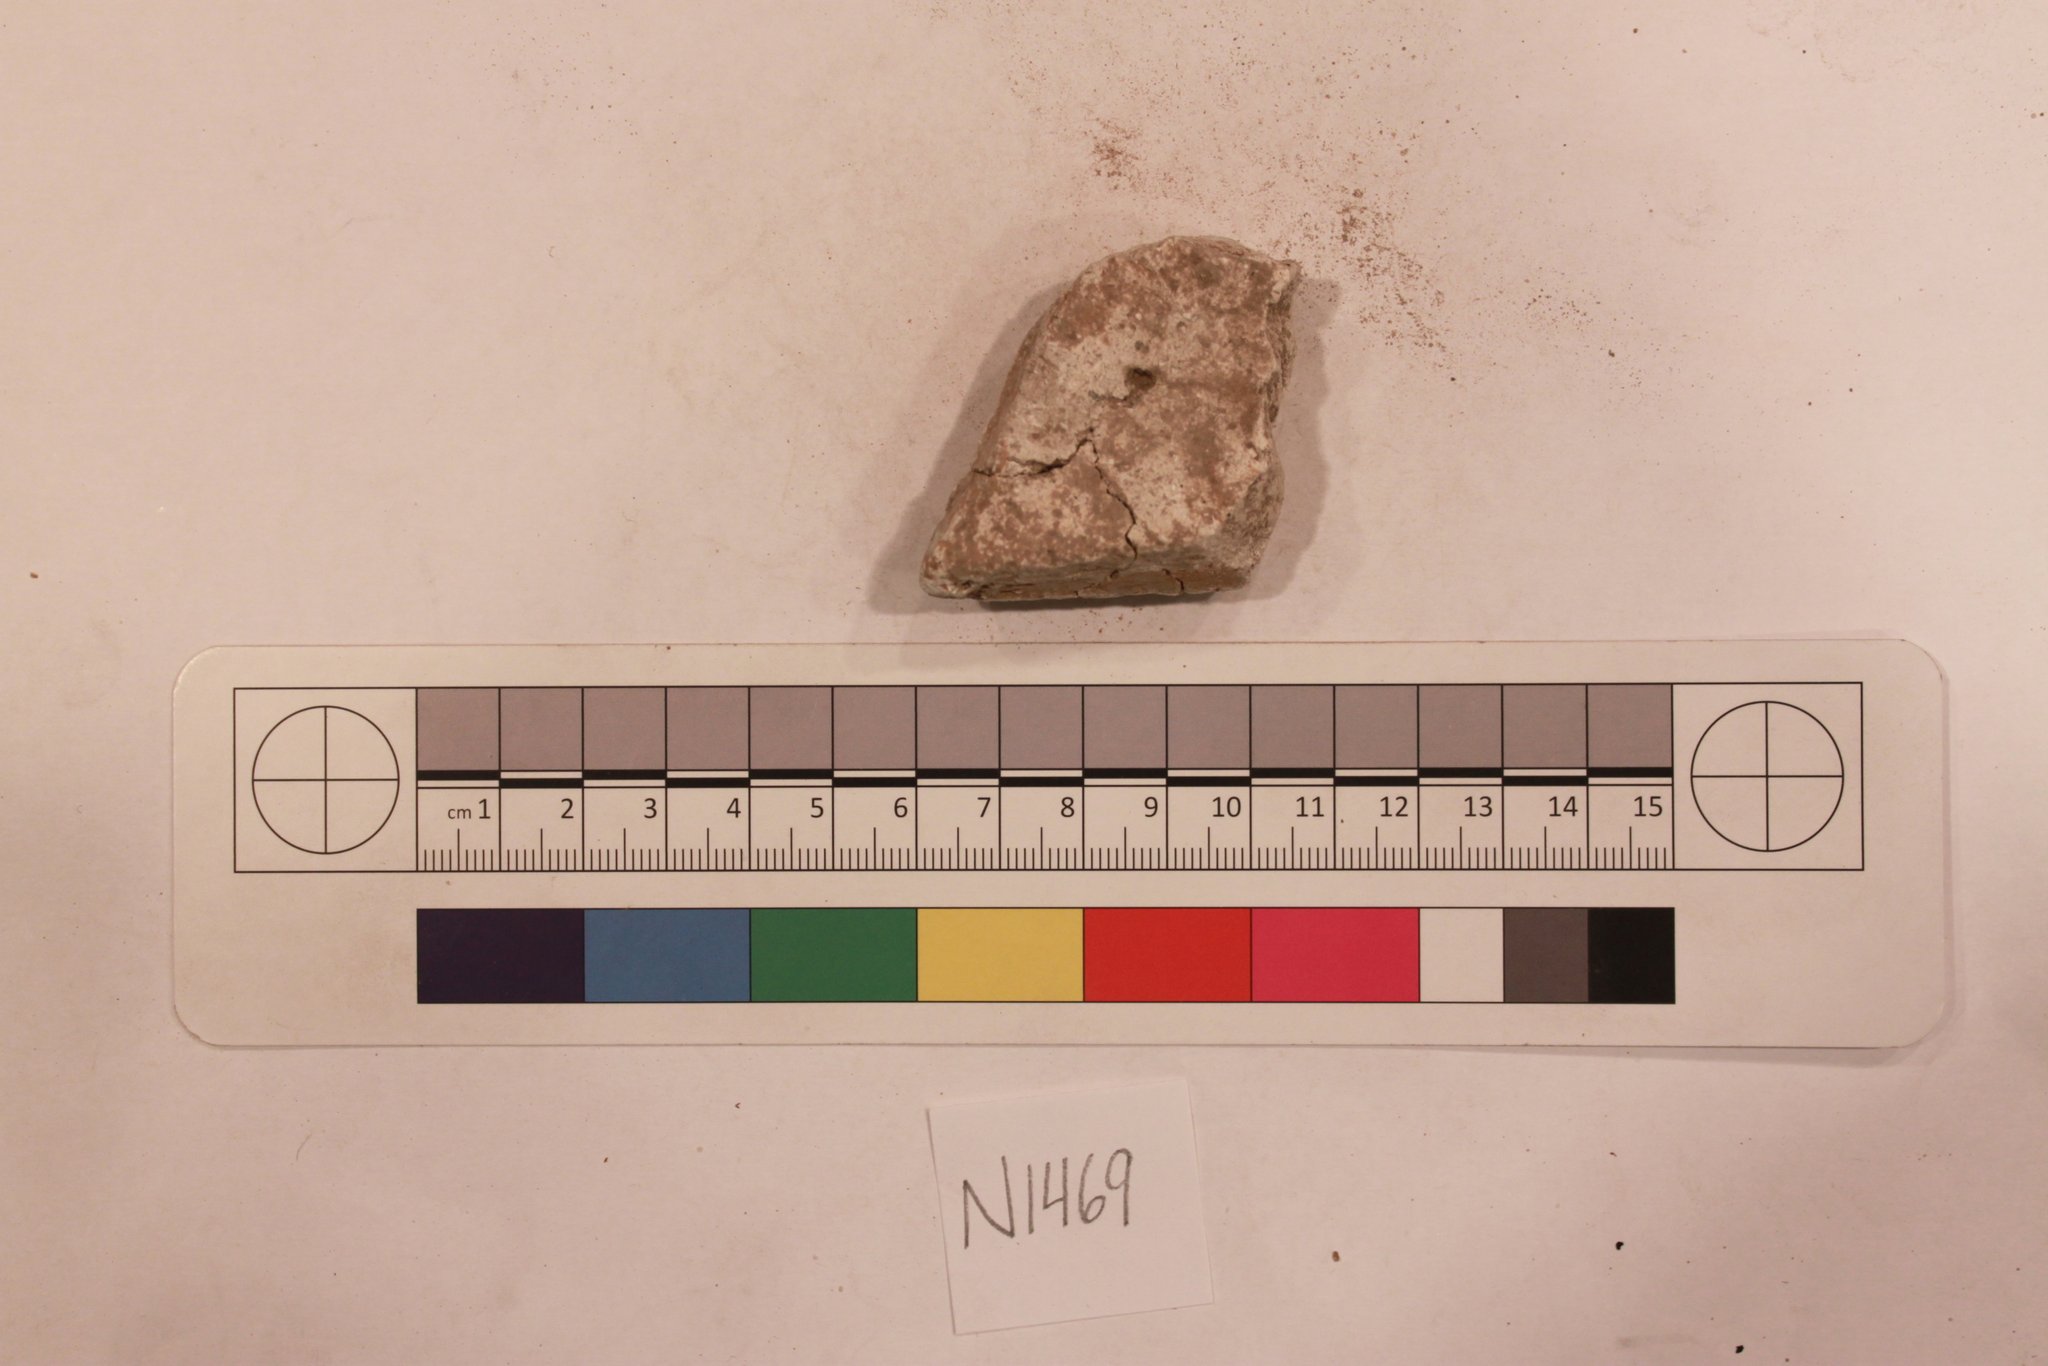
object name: fragment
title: Stucco Fragment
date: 701-1200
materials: plaster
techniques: carving, painting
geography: iran